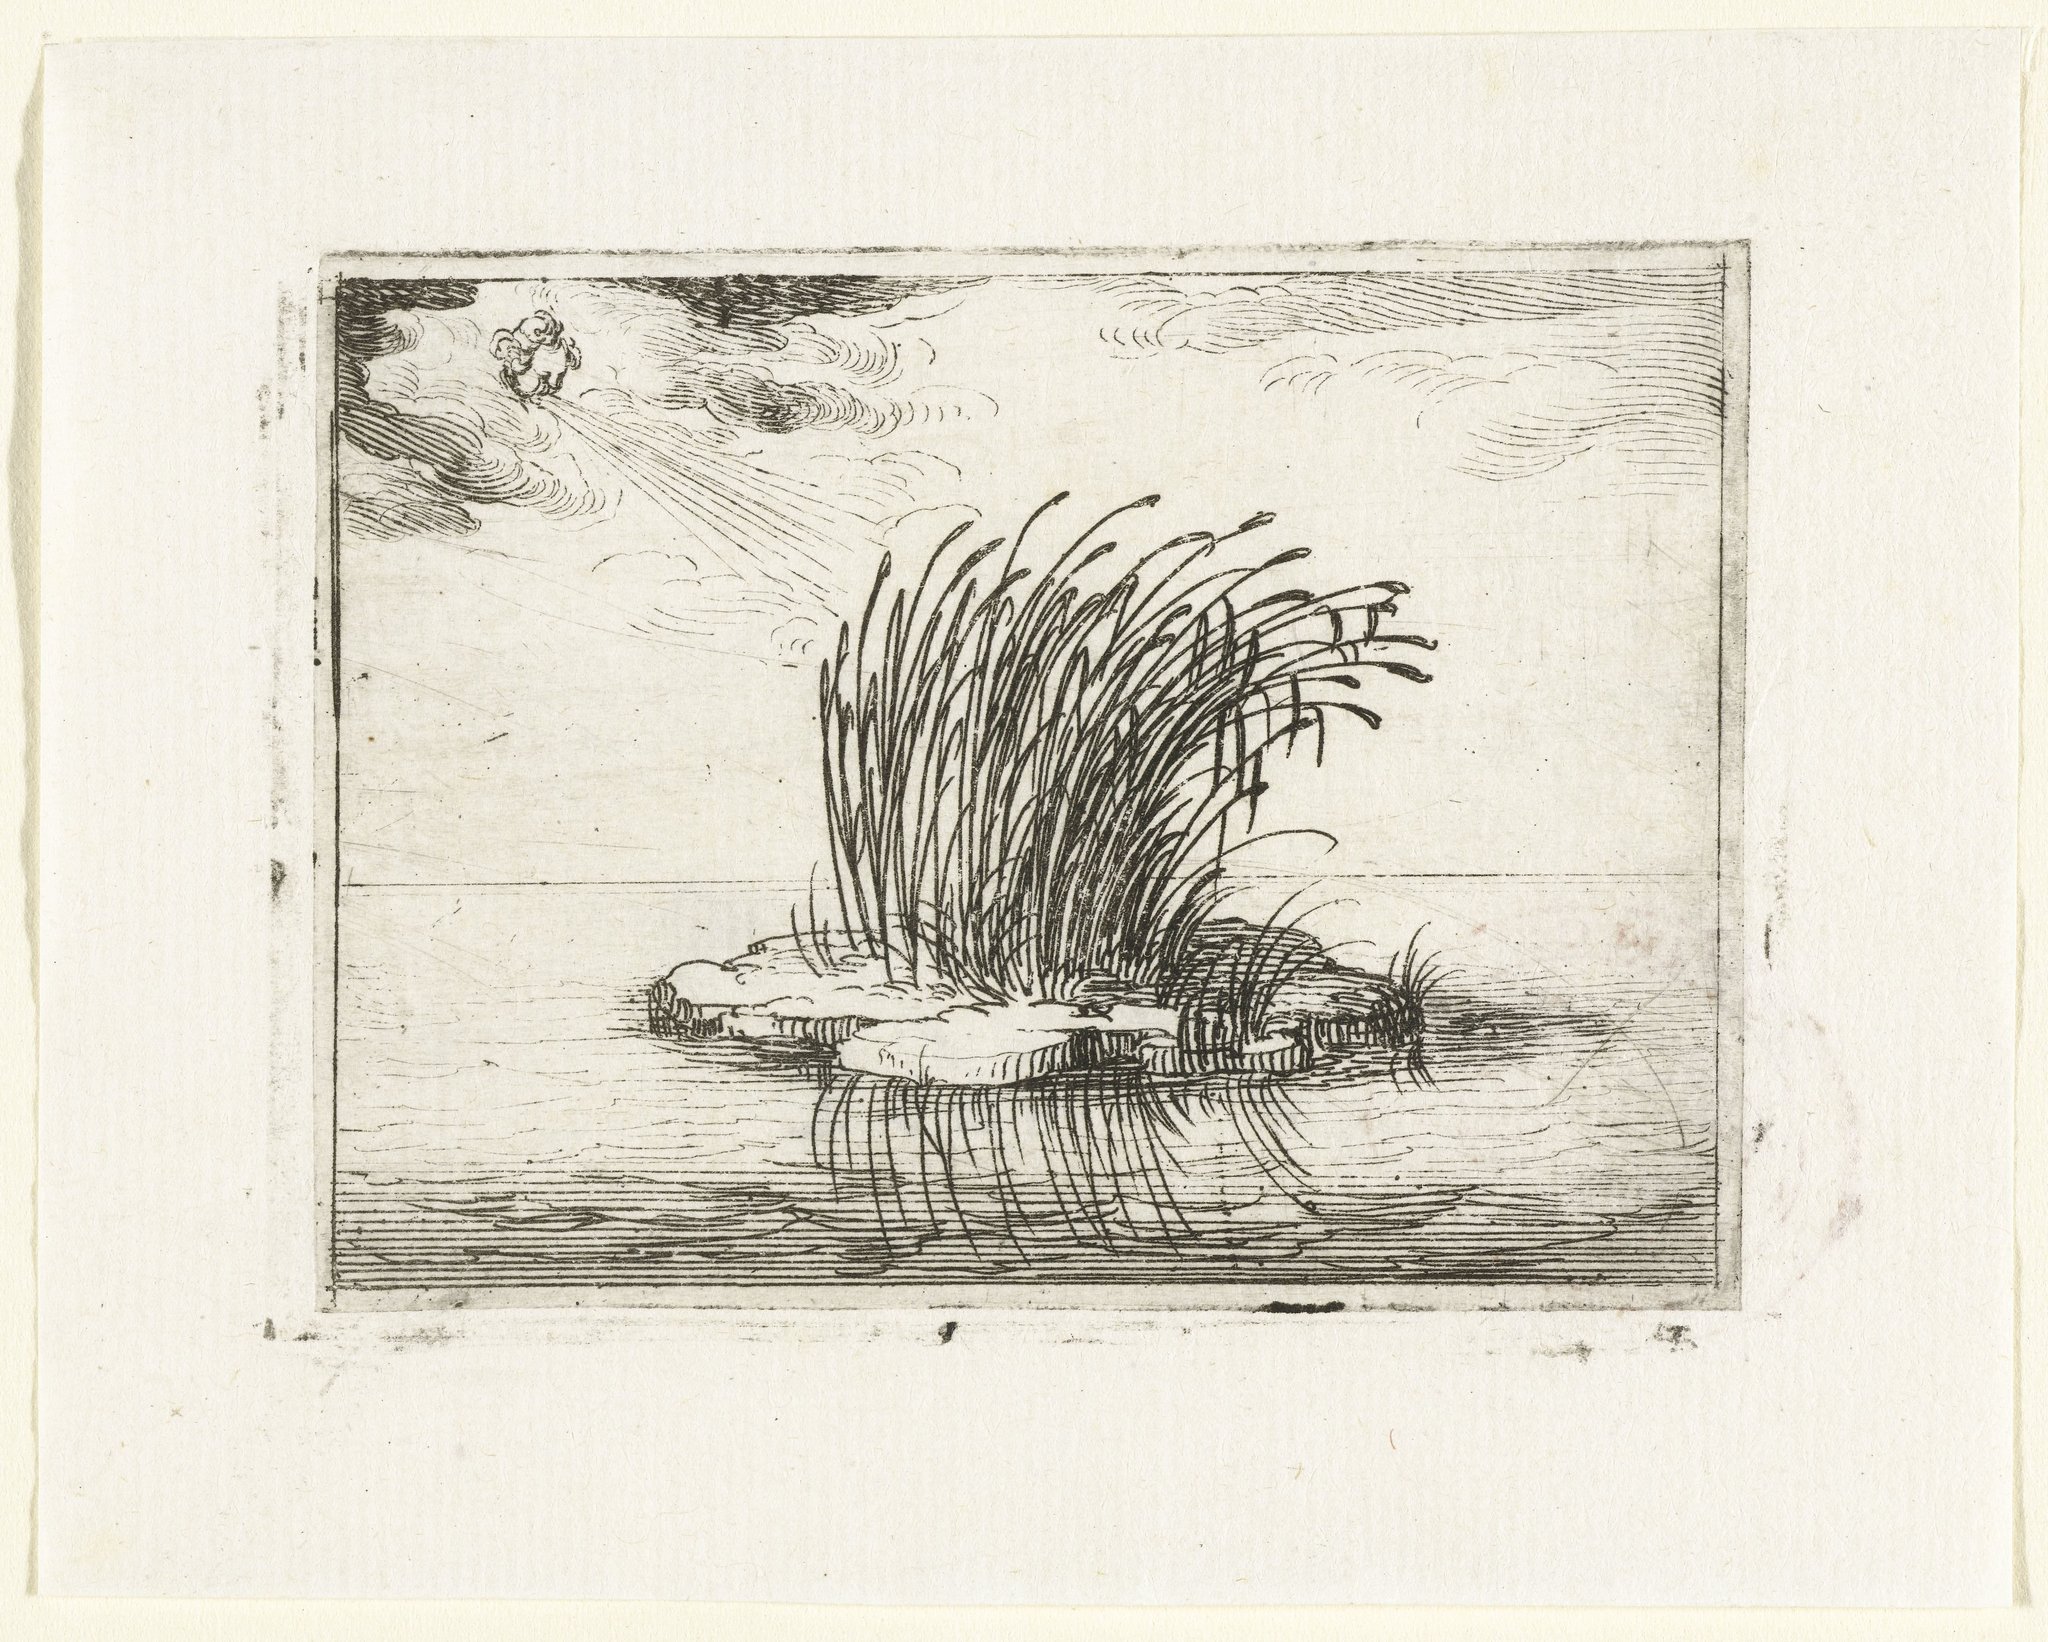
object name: print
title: Rietstengels in de wind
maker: jacques callot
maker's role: draughtsman, print maker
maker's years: 1592-1635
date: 1621-1635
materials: paper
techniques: etching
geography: nancy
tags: winds, plants and herbs: reed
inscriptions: collector's mark: Lugt 240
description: Voorstelling van rietstengels, wuivend in de wind, op een klein eilandje in het water. Dit blad is onderdeel van de embleemserie 'Kloosterleven in emblemen'. De tweede staat van deze serie behelst naast een geïllustreerde titelpagina en 26 emblemen nog een titelpagina en een blad met opdracht, beide in boekdruk zonder afbeelding.